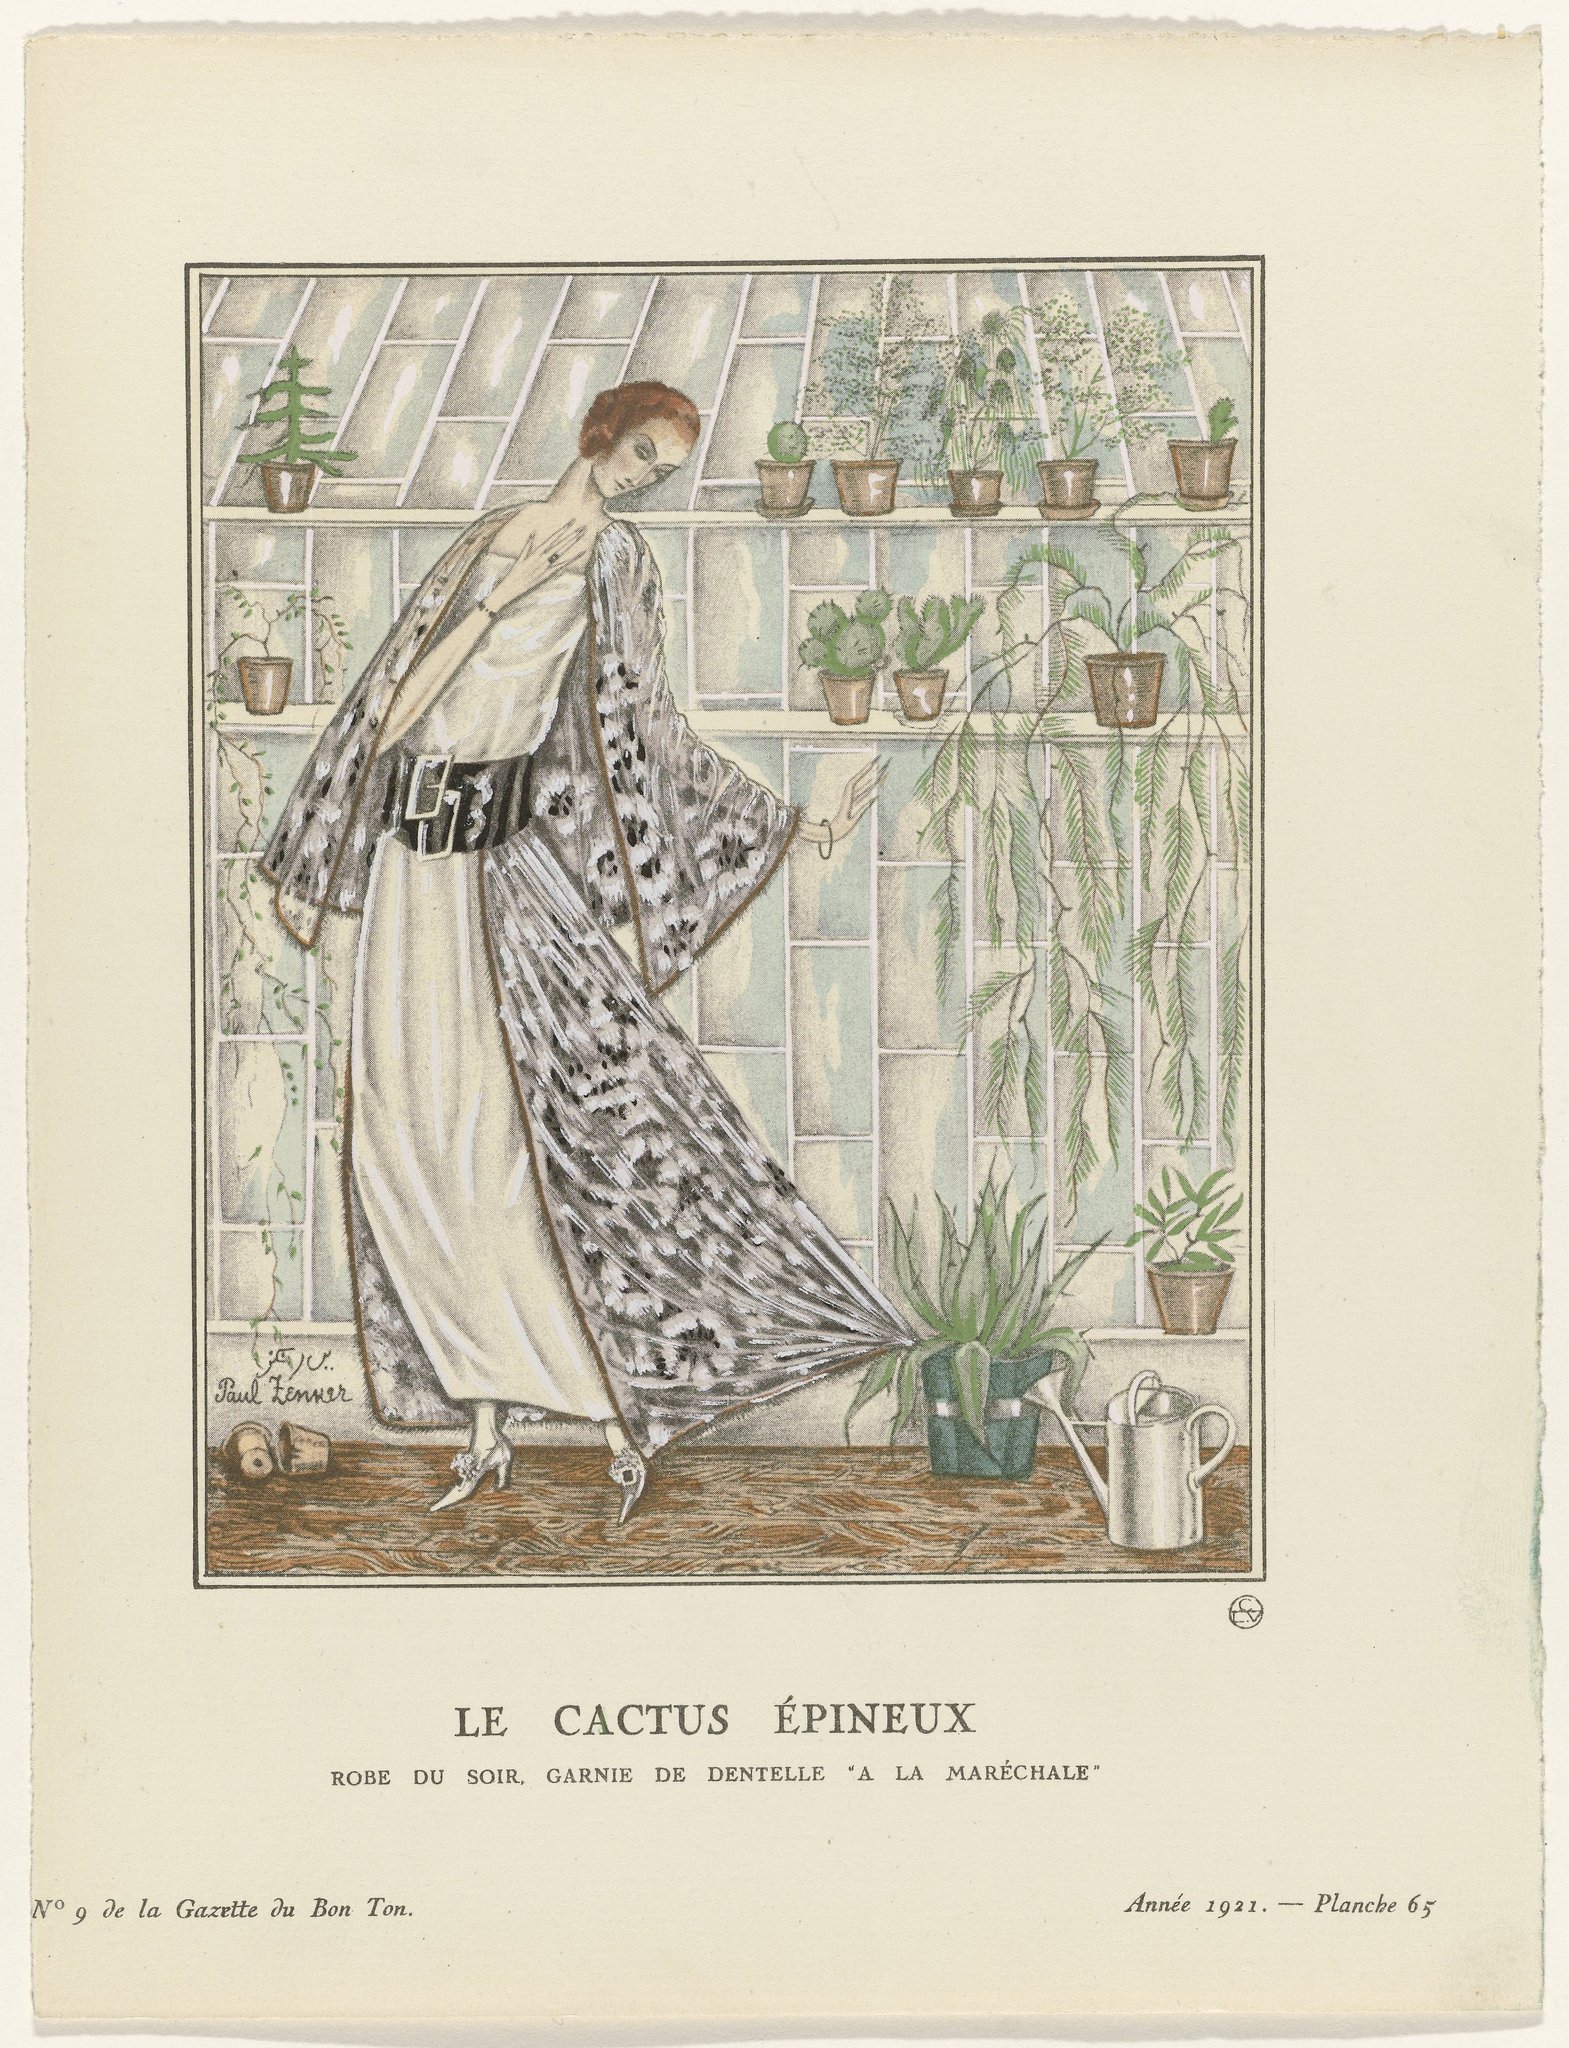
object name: fashion print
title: Gazette du Bon Ton, 1921 - No. 9 : Le cactus épineux / Robe du soir, garnie de dentelle "A la Maréchale"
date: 1921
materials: paper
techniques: hand coloring, letterpress printing, photochemical processes, pochoir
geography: geneva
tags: dress, gown: evening dress (+ women's clothes), lace (+ women's clothes), fashion plates, plants and herbs: cactus, greenhouse, orangery, bracelet, wristlet (+ women's clothes)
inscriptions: date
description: Staande vrouw in een glazen tuinhuis met cactussen. Zij draagt een avondjapon van crêpe en kant, afgezet met bont. Haar japon blijft met de zoom aan een cactus hangen. Planche 65 uit Gazette du Bon Ton 1921, No. 9. Uitleg over de kleding op pagina "Explication des Planches Hors-Texte. Contenues dans le numéro 9."